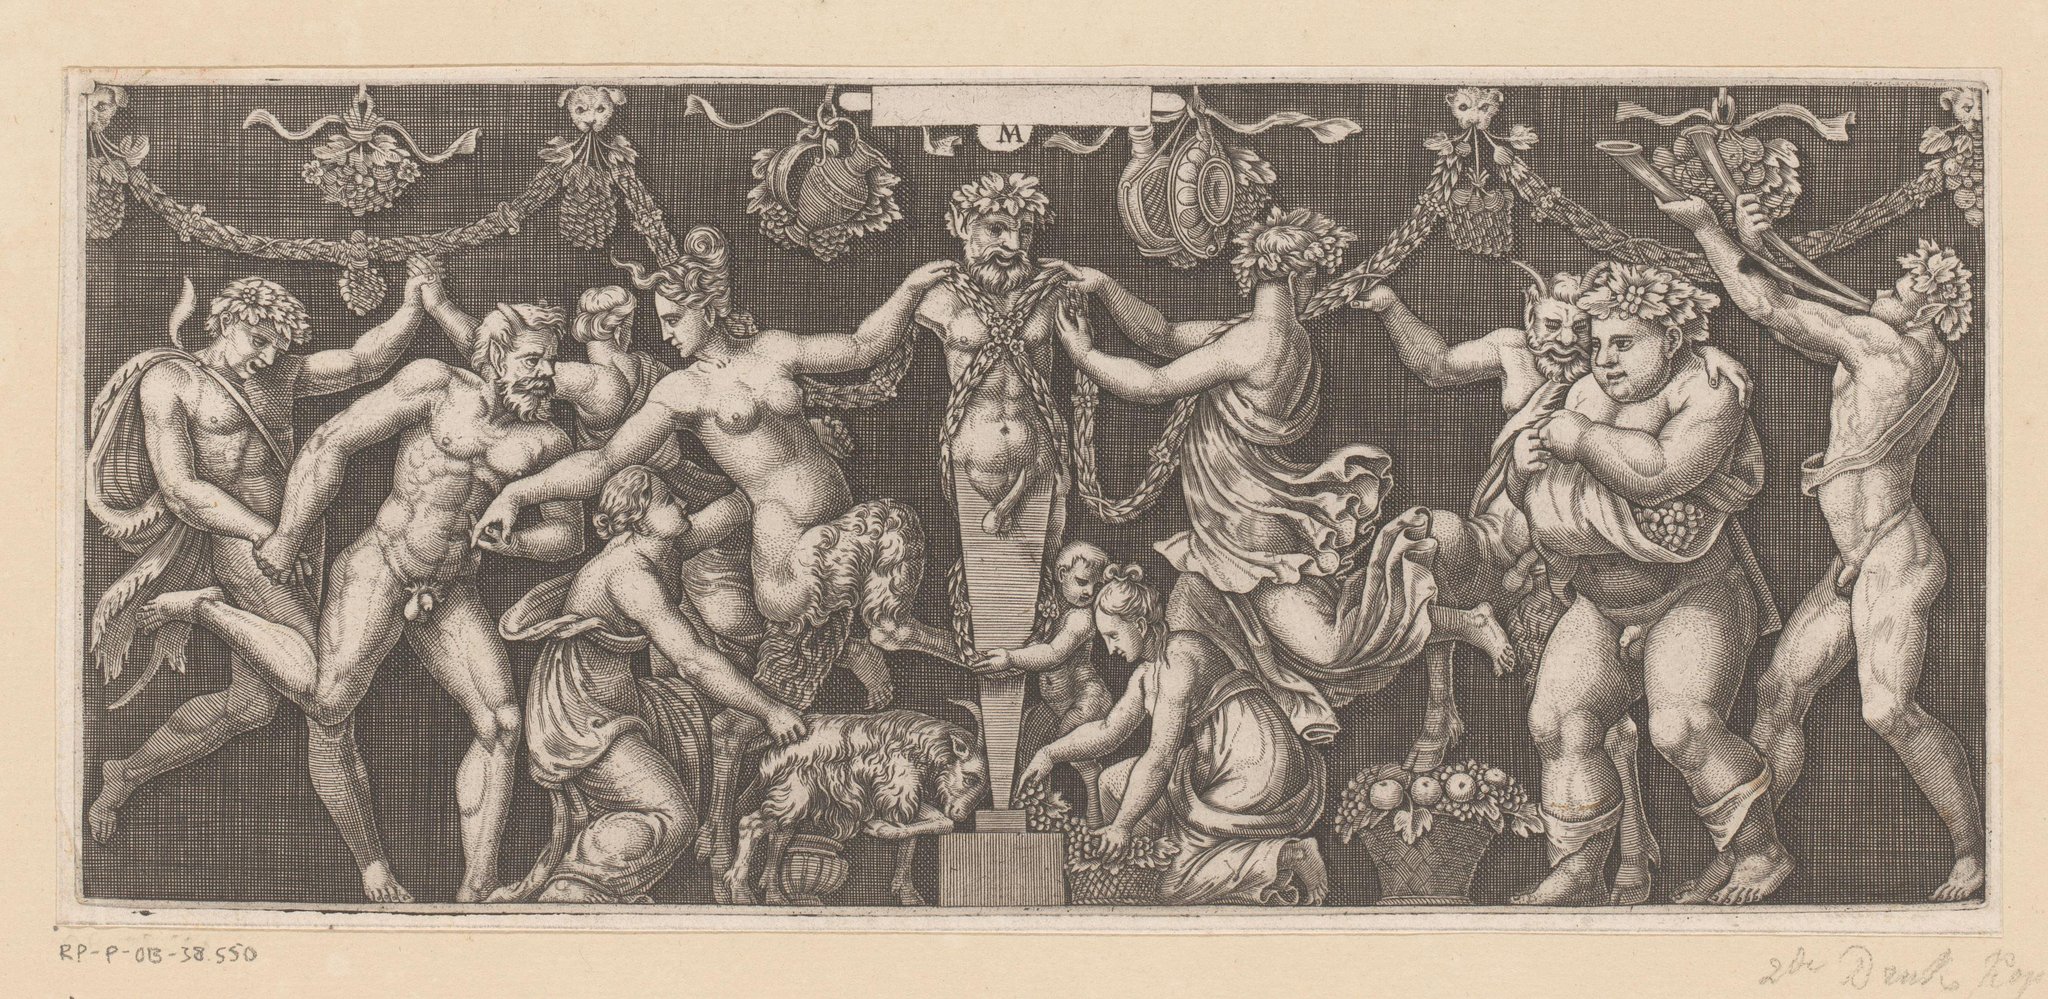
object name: print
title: Offer aan Priapus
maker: Anonymous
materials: paper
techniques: engraving, intaglio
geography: italy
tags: horn, trumpet, cornet, trombone, tuba, maenad(s), female bacchant(es), animal sacrifice ~ roman religion, male bacchant(es), priapus-herm, satyr(s) (in general)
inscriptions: collector's mark: Lugt 240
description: In het midden staat de vruchtbaarheidsgod Priapus in de vorm van een herme. Om hem heen dansen saters en maenaden. Rechts Bacchus en een figuur blazend op een dubbele hoorn. Onderaan de herme wordt een ram aan Priapus geofferd. Midden boven een cartouche.